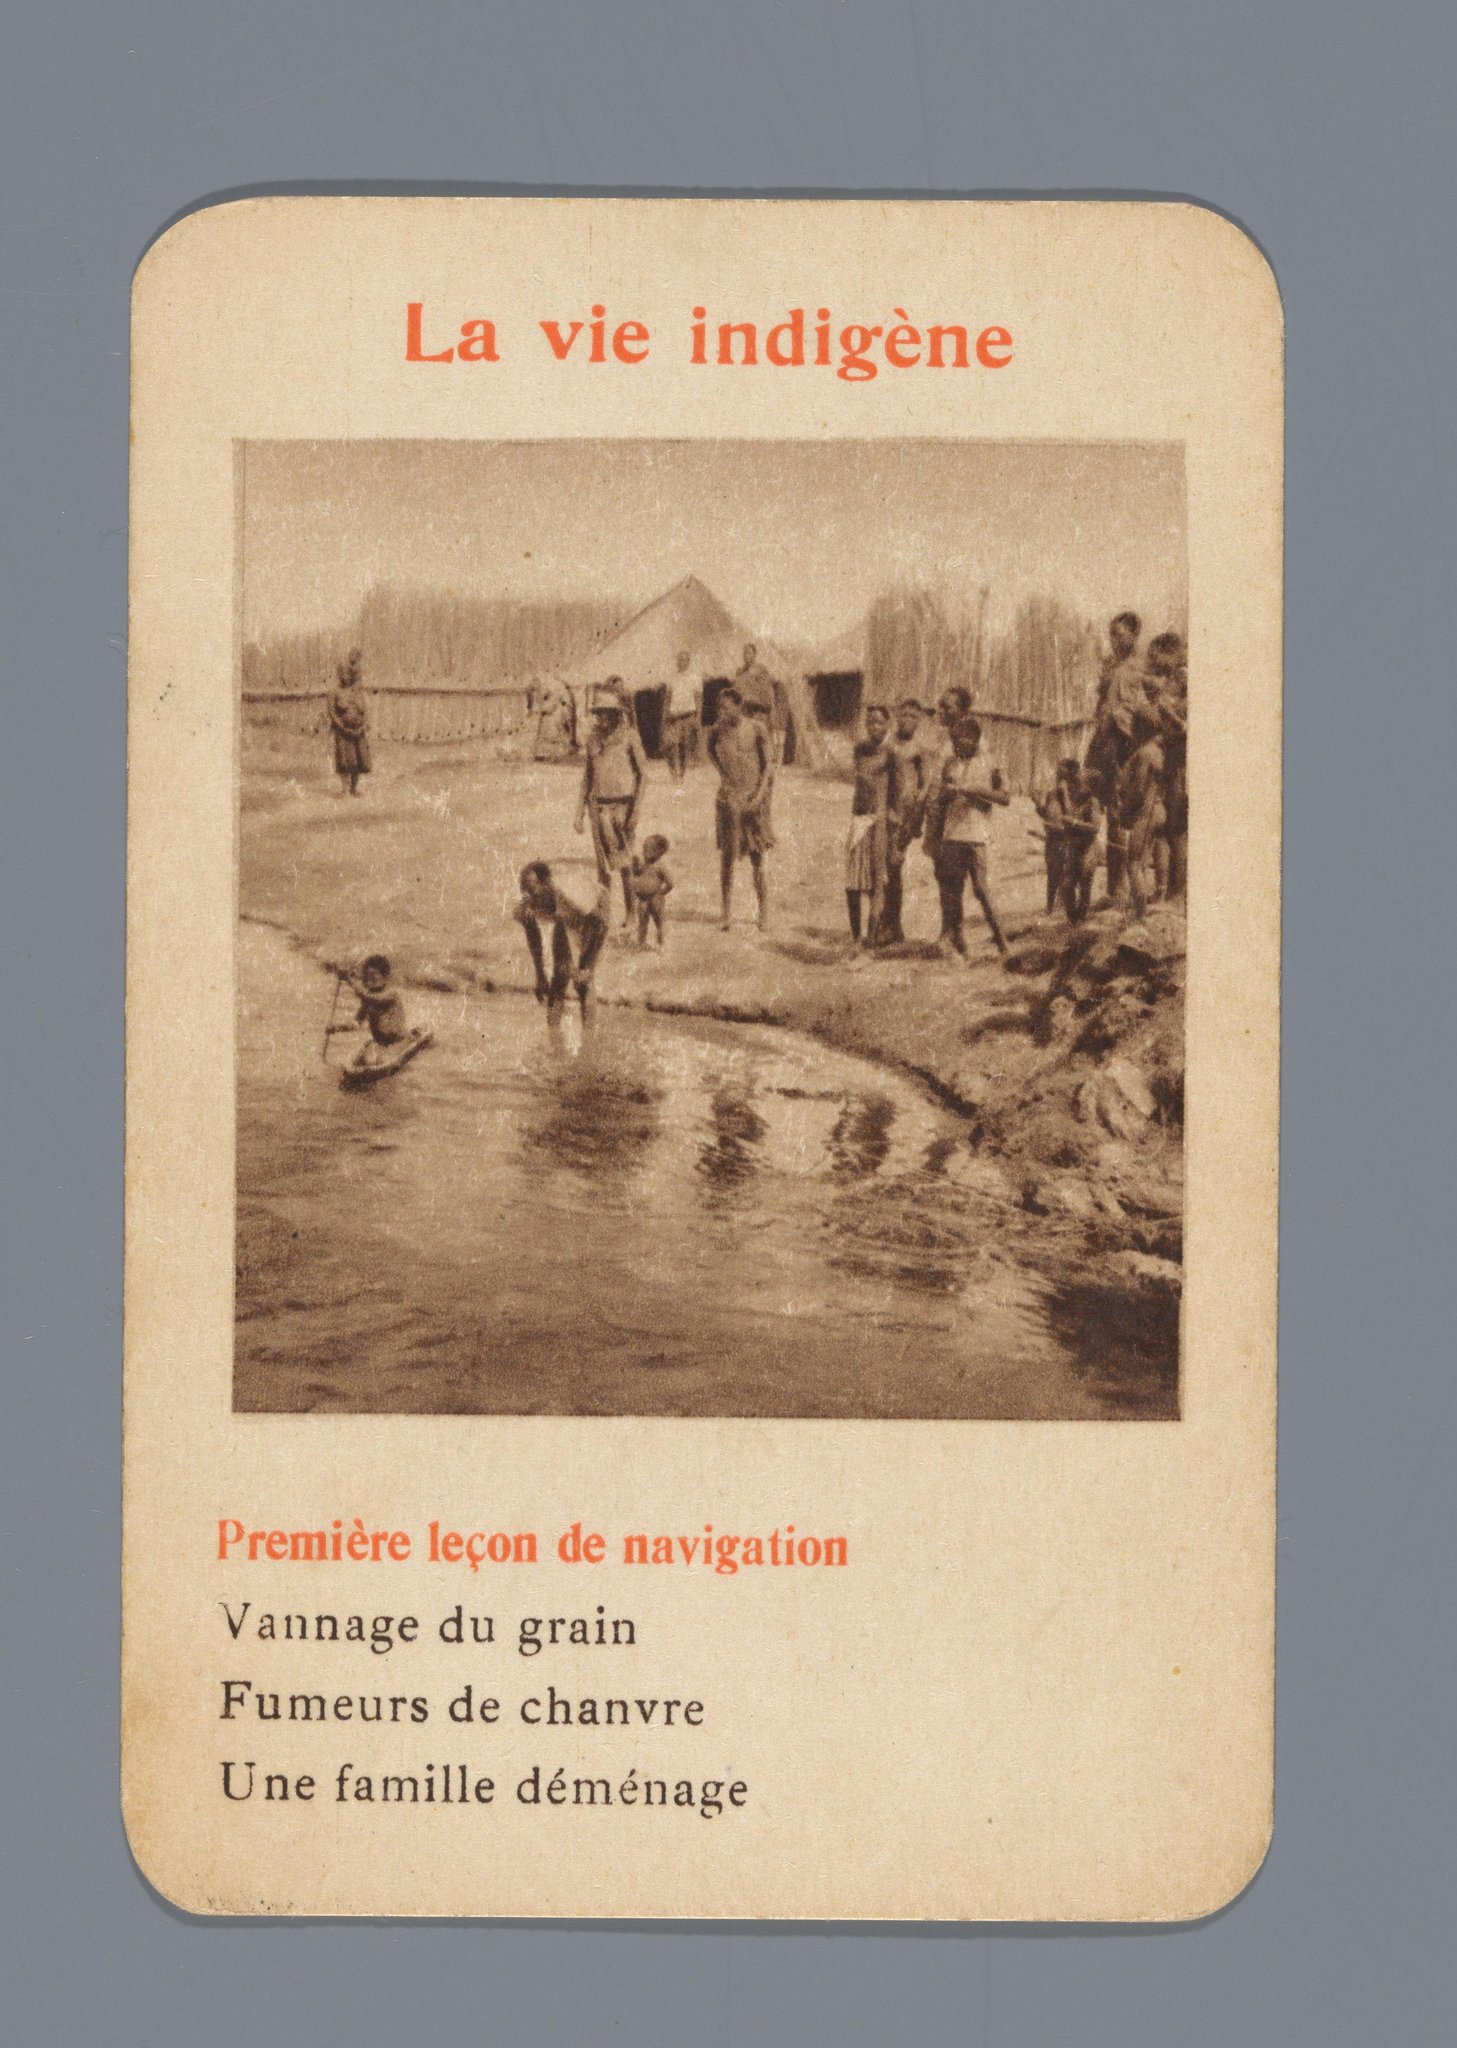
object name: photomechanical print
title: Première leçon de navigation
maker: Anonymous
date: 1900-1920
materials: cardboard, paper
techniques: rotogravure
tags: rowing-boat, canoe, etc., card games